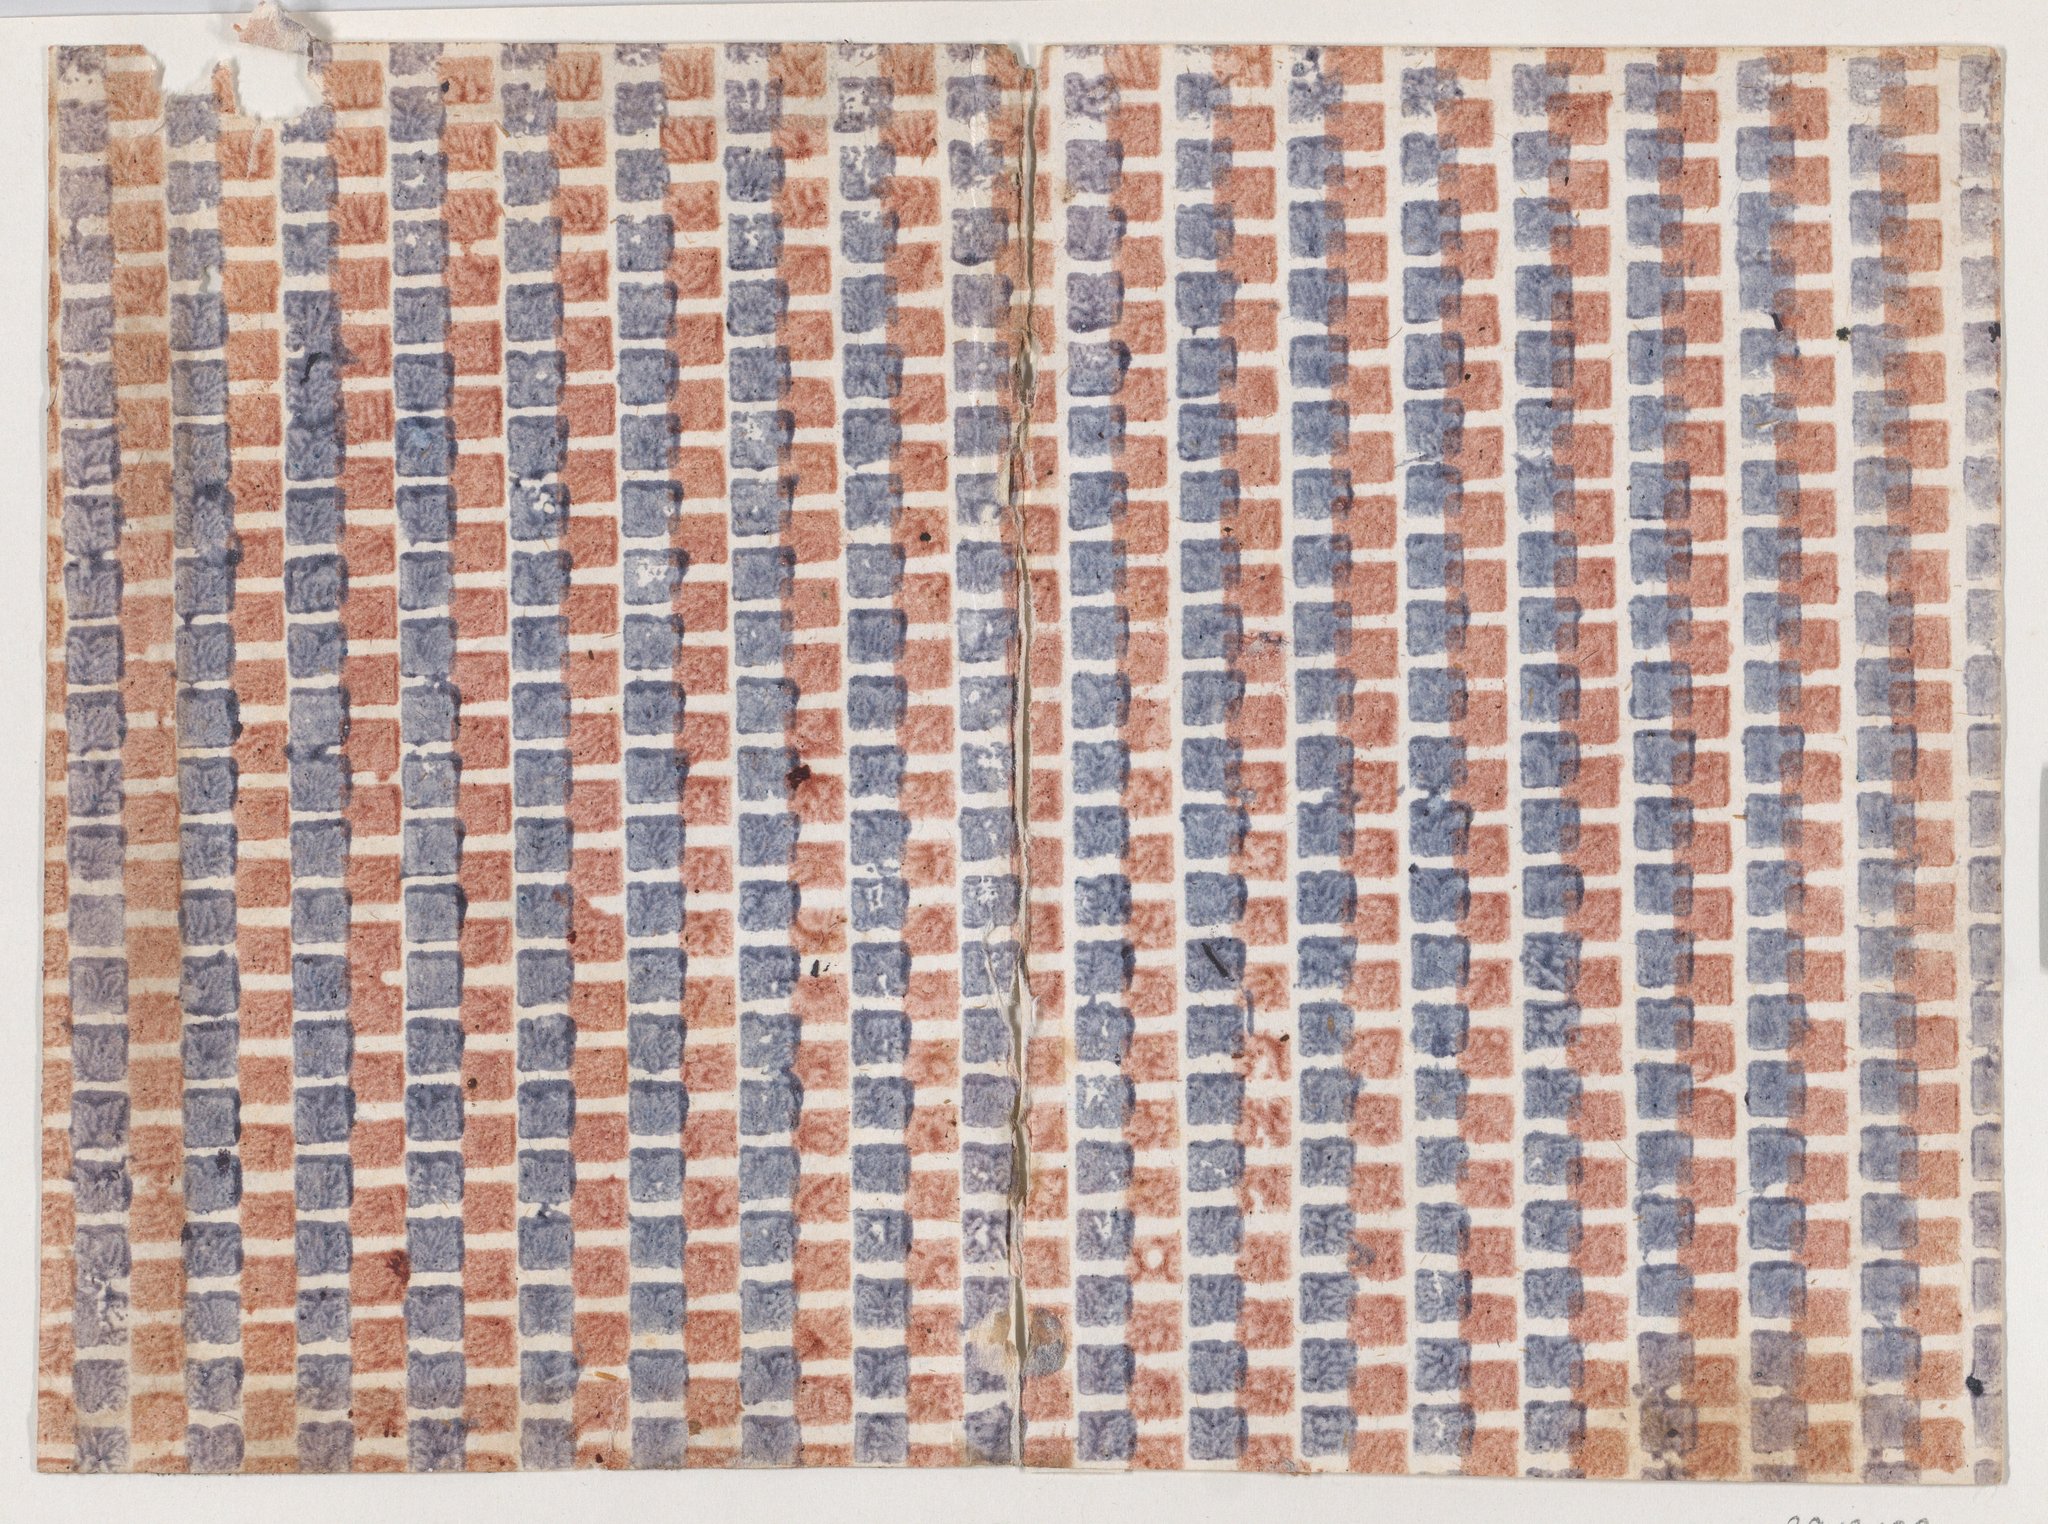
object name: print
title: Book cover with overall pattern of blue and red squares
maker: Anonymous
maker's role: artist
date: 1801-1900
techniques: relief print